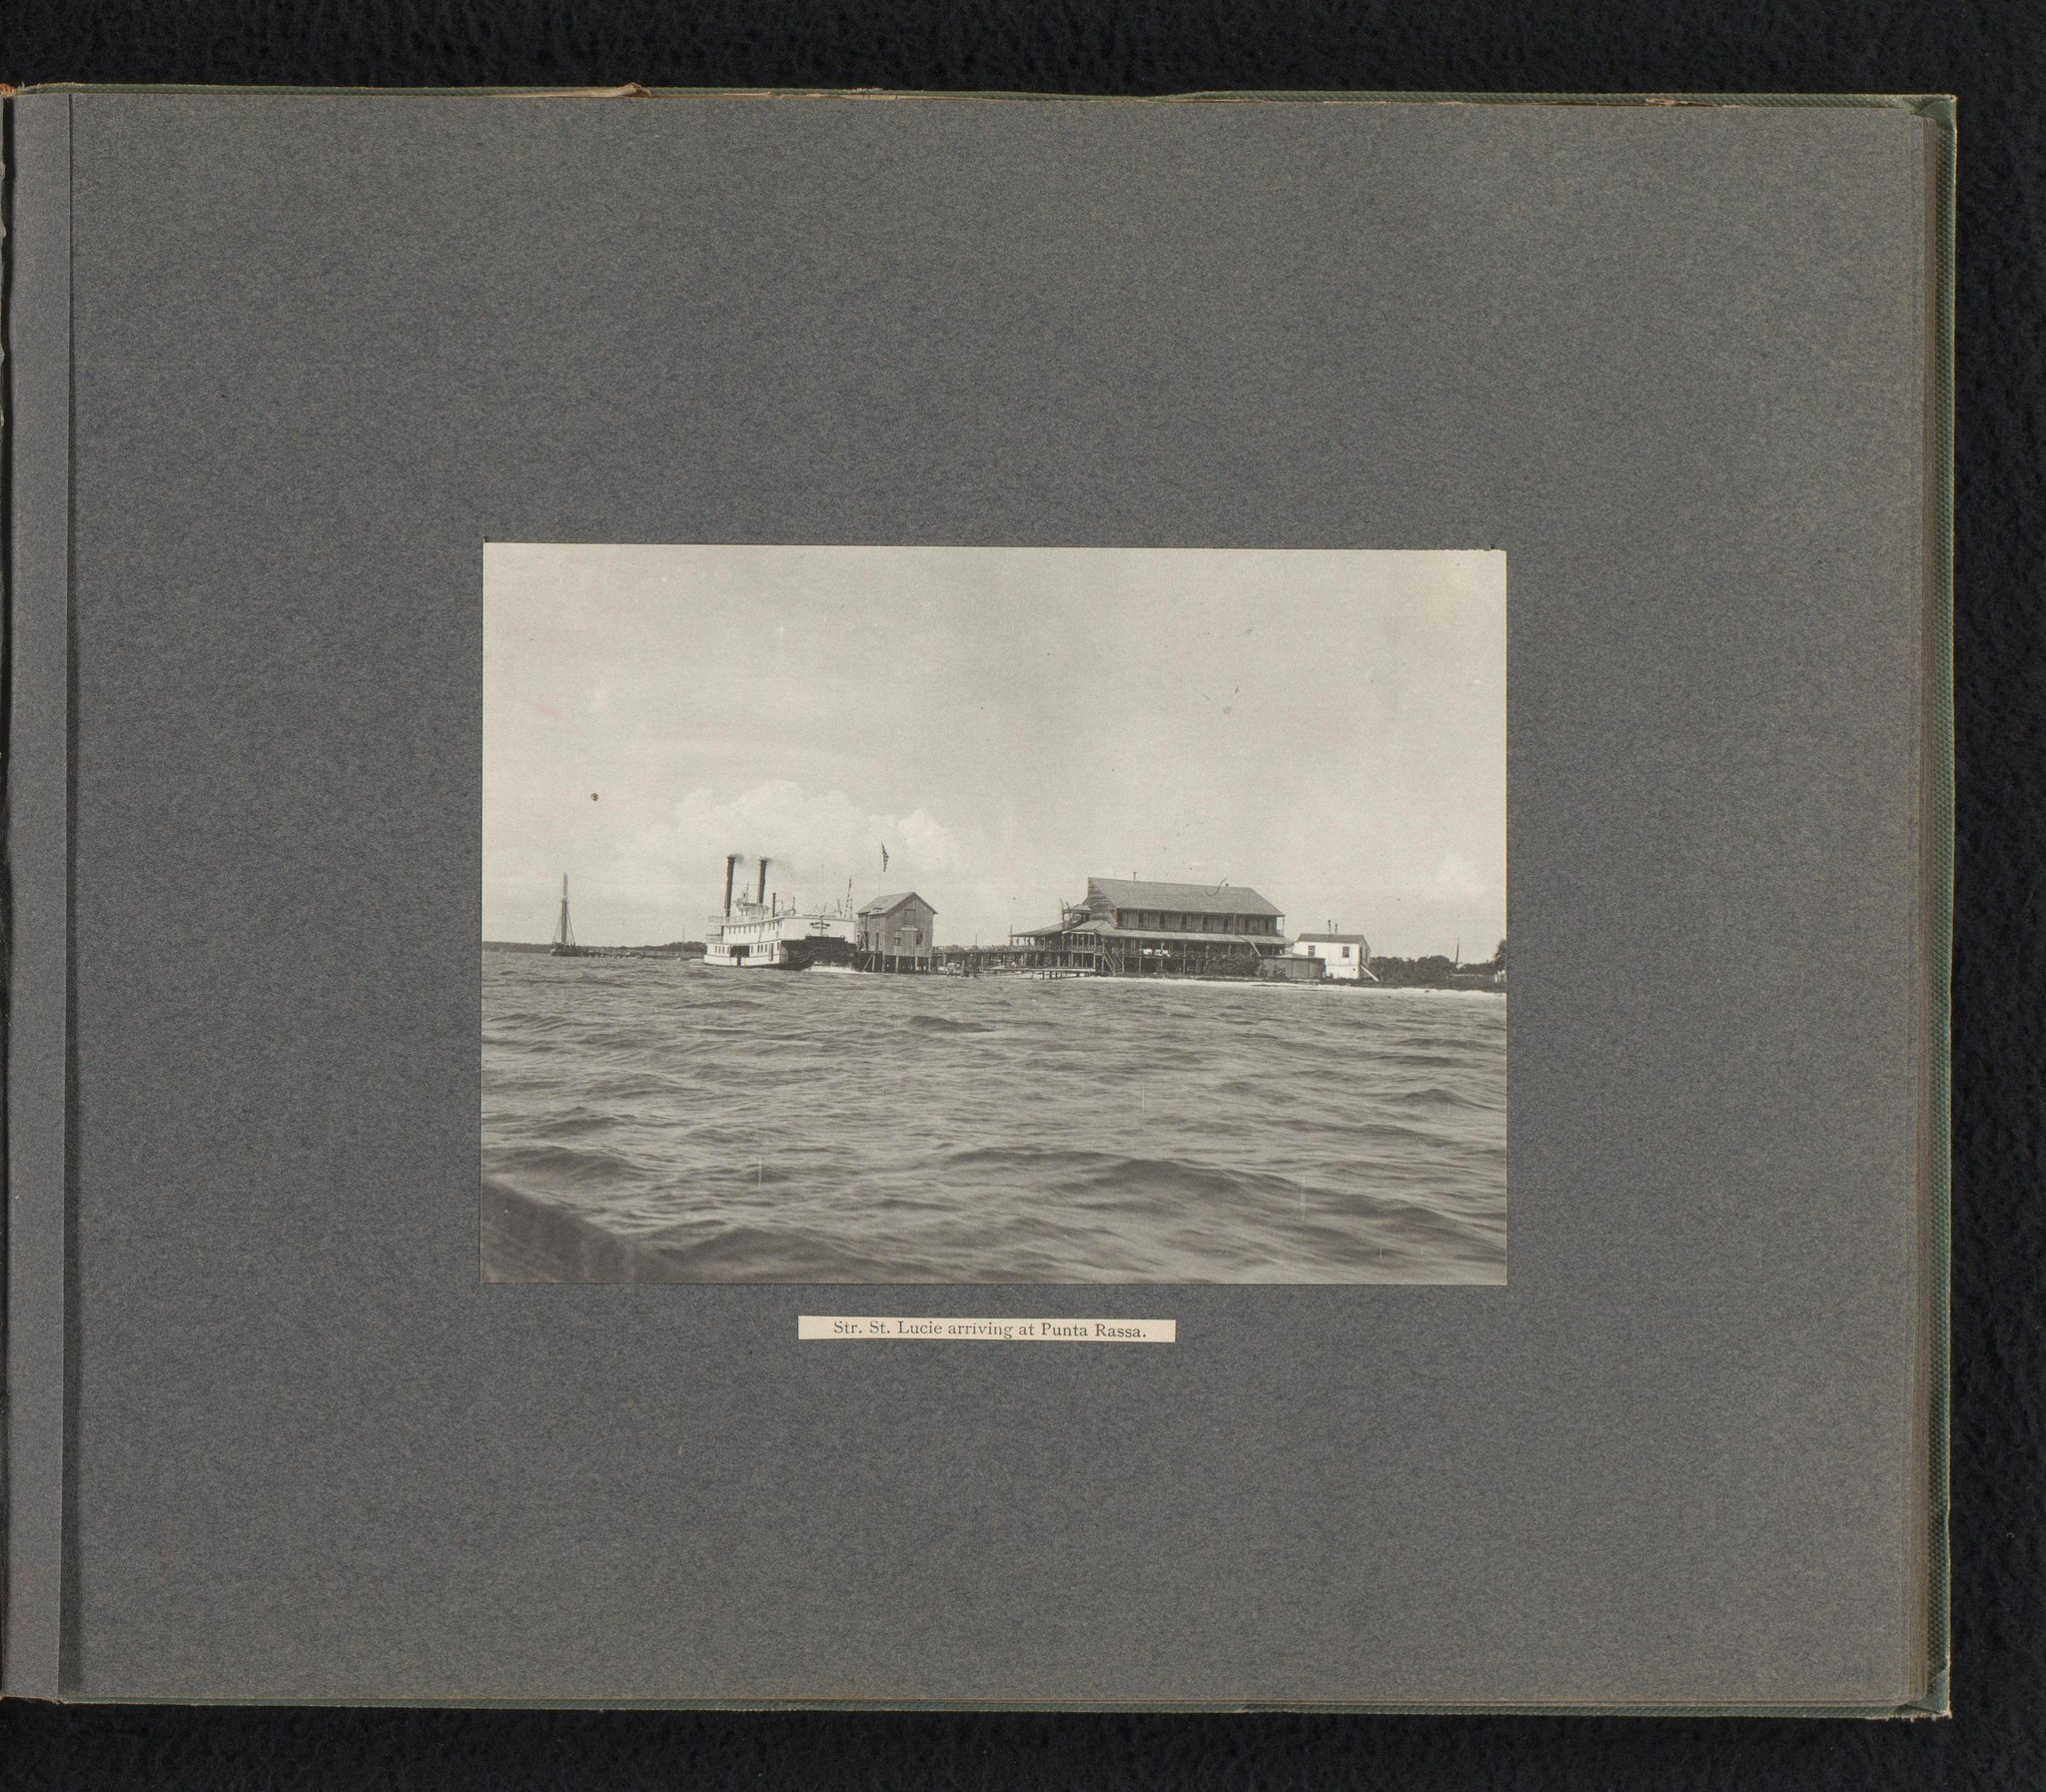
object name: photograph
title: Str. St. Lucie arriving at Punta Rassa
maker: Anonymous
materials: paper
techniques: platinum process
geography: punta rassa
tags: ships (in general), exterior ~ representation of a building, coast